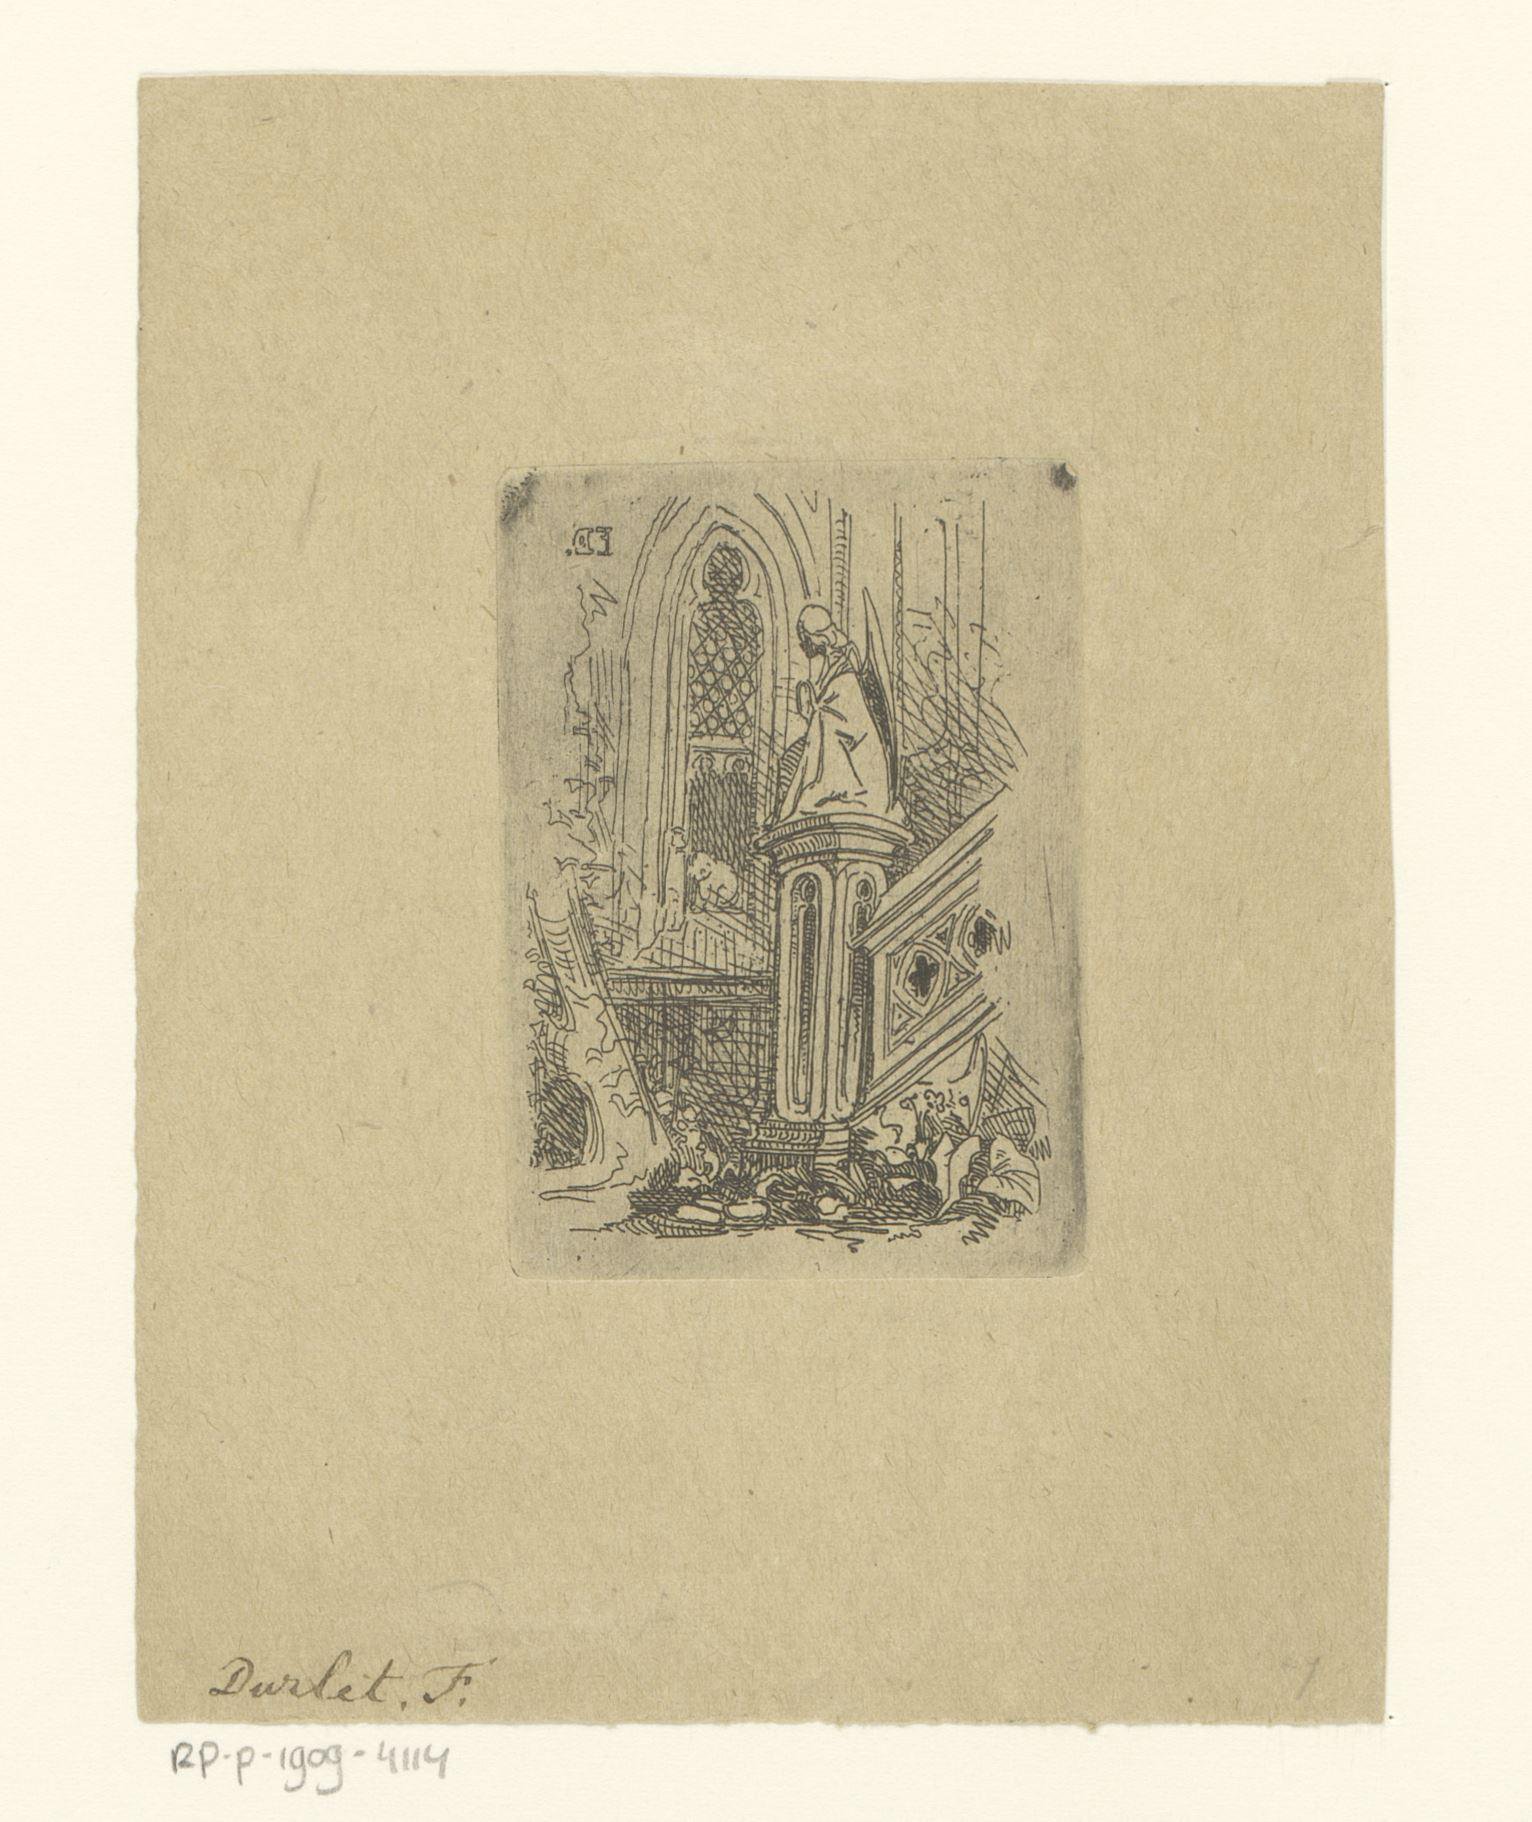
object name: print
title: Boogvenster en gotische trap met beeld van een engel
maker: franciscus andreas durlet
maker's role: draughtsman, print maker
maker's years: 1816-1867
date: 1826-1867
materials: paper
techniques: etching, intaglio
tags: church-window, e.g. rose-window, staircase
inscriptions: collector's mark: Lugt 2228